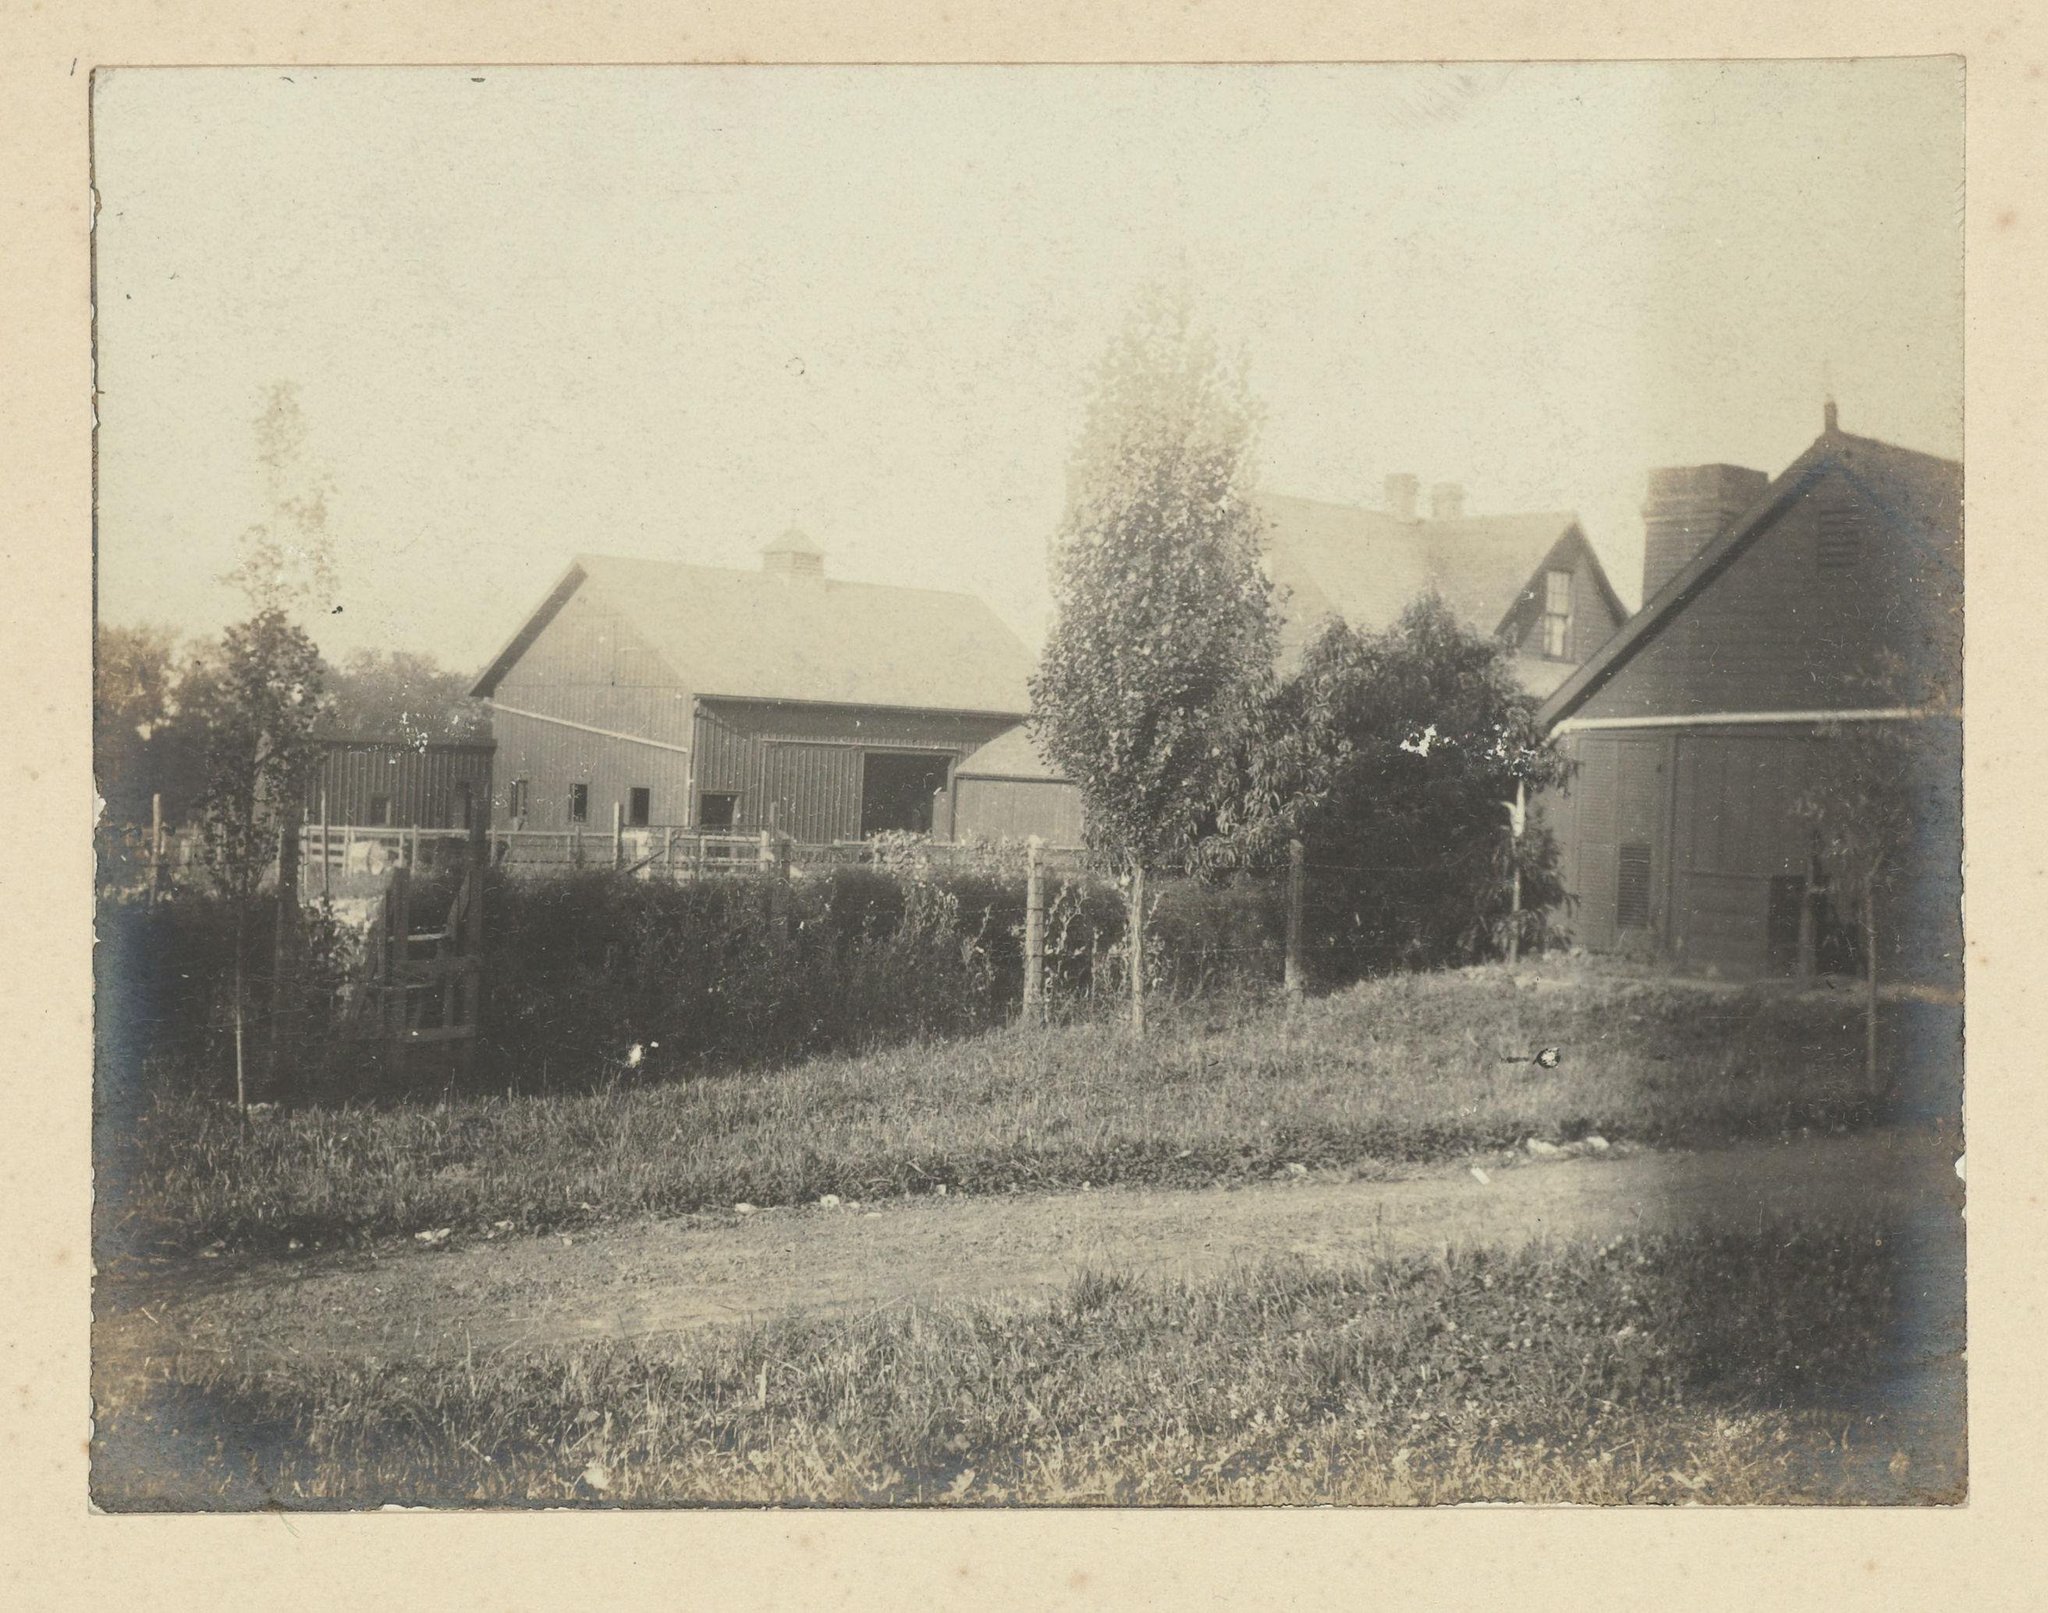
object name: photograph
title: Boerderij van Ives [?] tijdens de wereldtentoonstelling in St. Louis (Louisiana Purchase Exposition), 1904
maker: jan schüller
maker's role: draughtsman, painter, print maker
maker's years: 1871-1915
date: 1904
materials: cardboard, paper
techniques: gelatin silver print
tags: saint louis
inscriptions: annotation: ‘Boerderij van Ives [?]’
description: Boerderij van Ives [?] tijdens de wereldtentoonstelling in St. Louis (Louisiana Purchase Exposition), 1904.